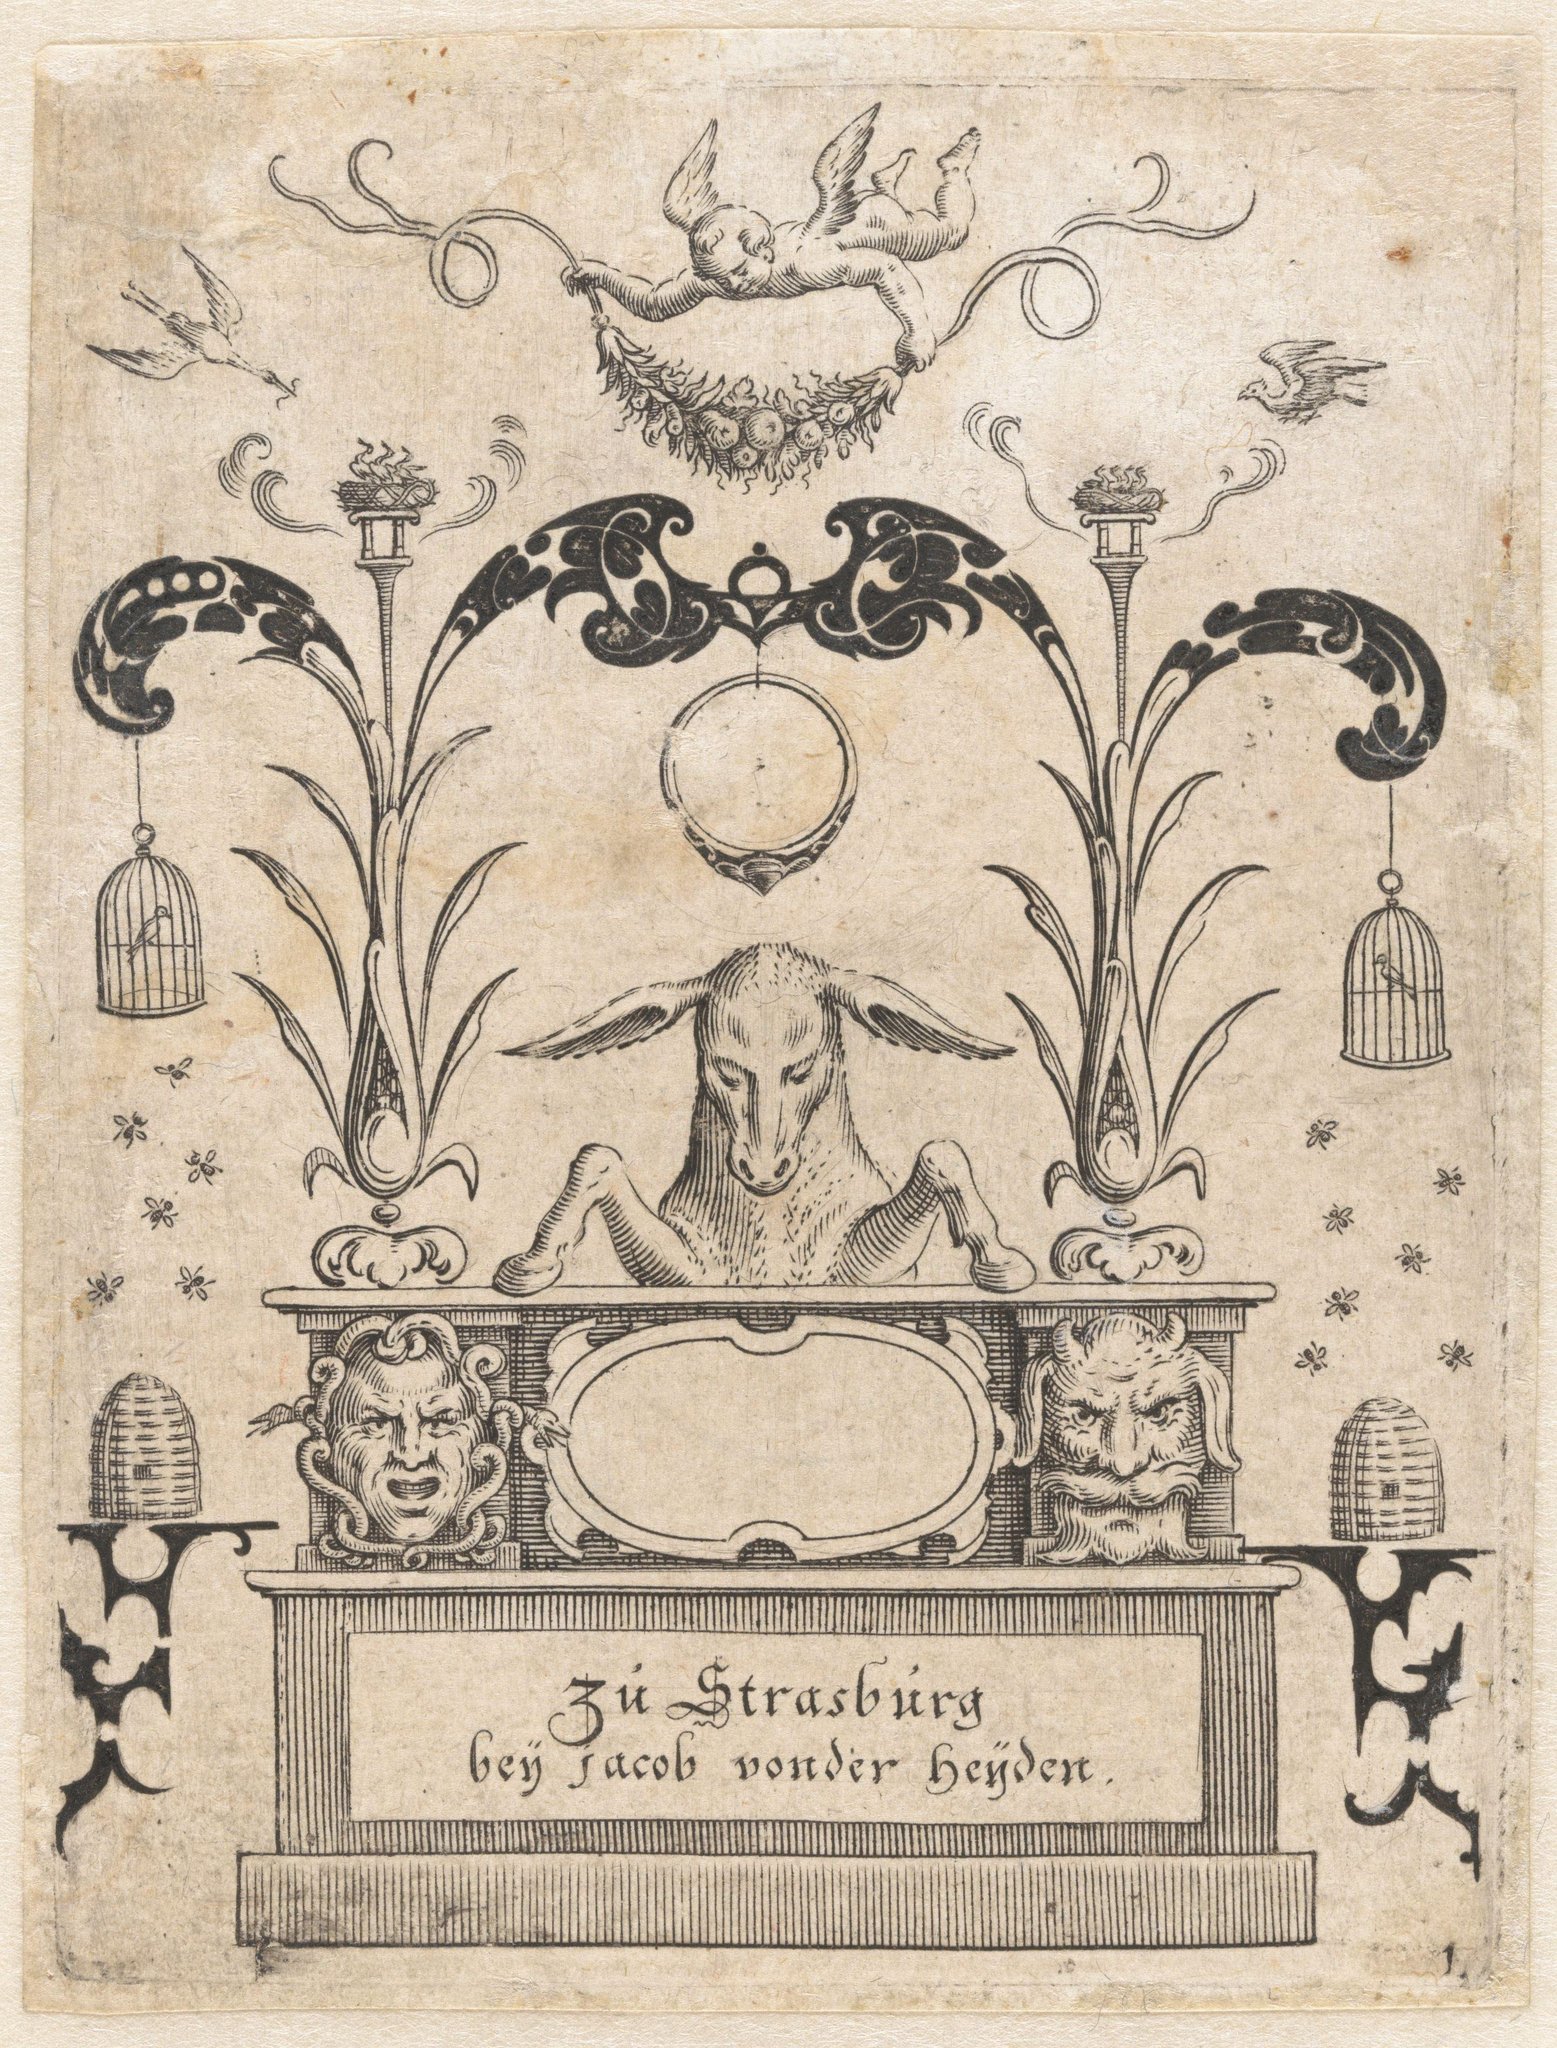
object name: ornament print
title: Titelprent van serie juwelen- en sieradenornamenten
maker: jacob von der heijden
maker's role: print maker, publisher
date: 1619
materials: paper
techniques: engraving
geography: straatsburg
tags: cherubs, i.e. children's heads with wings, ornaments ~ art, birds, bee-hive, ornament ~ cartouche, mask, mascaron ~ ornament, insects: bee, ring, goat, base (~ column, pillar), bird in a cage, foliage, tendrils, branches ~ ornament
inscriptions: collector's mark: Lugt 2542, collector's mark: Lugt 2228, signature: ‘Zu Strasburg / beij Jacob vonder heijden’, collector's mark: Lugt 2760, number: ‘1’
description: Gespiegelde kopie van titelprent. Twee planten met hoge stelen omlijsten het geheel met daaraan twee vogelkooien en een ring. Bovenaan heeft een cherubijn een guirlande met fruit vast met links en rechts een vogel. In het midden leunt een geit op een basement met daarin een leeg cartouche geflankt door twee maskers en daaronder een tekst. In de onderste hoeken zijn vier motieven in het zwart; op twee van hen is een bijenkorf geplaatst.